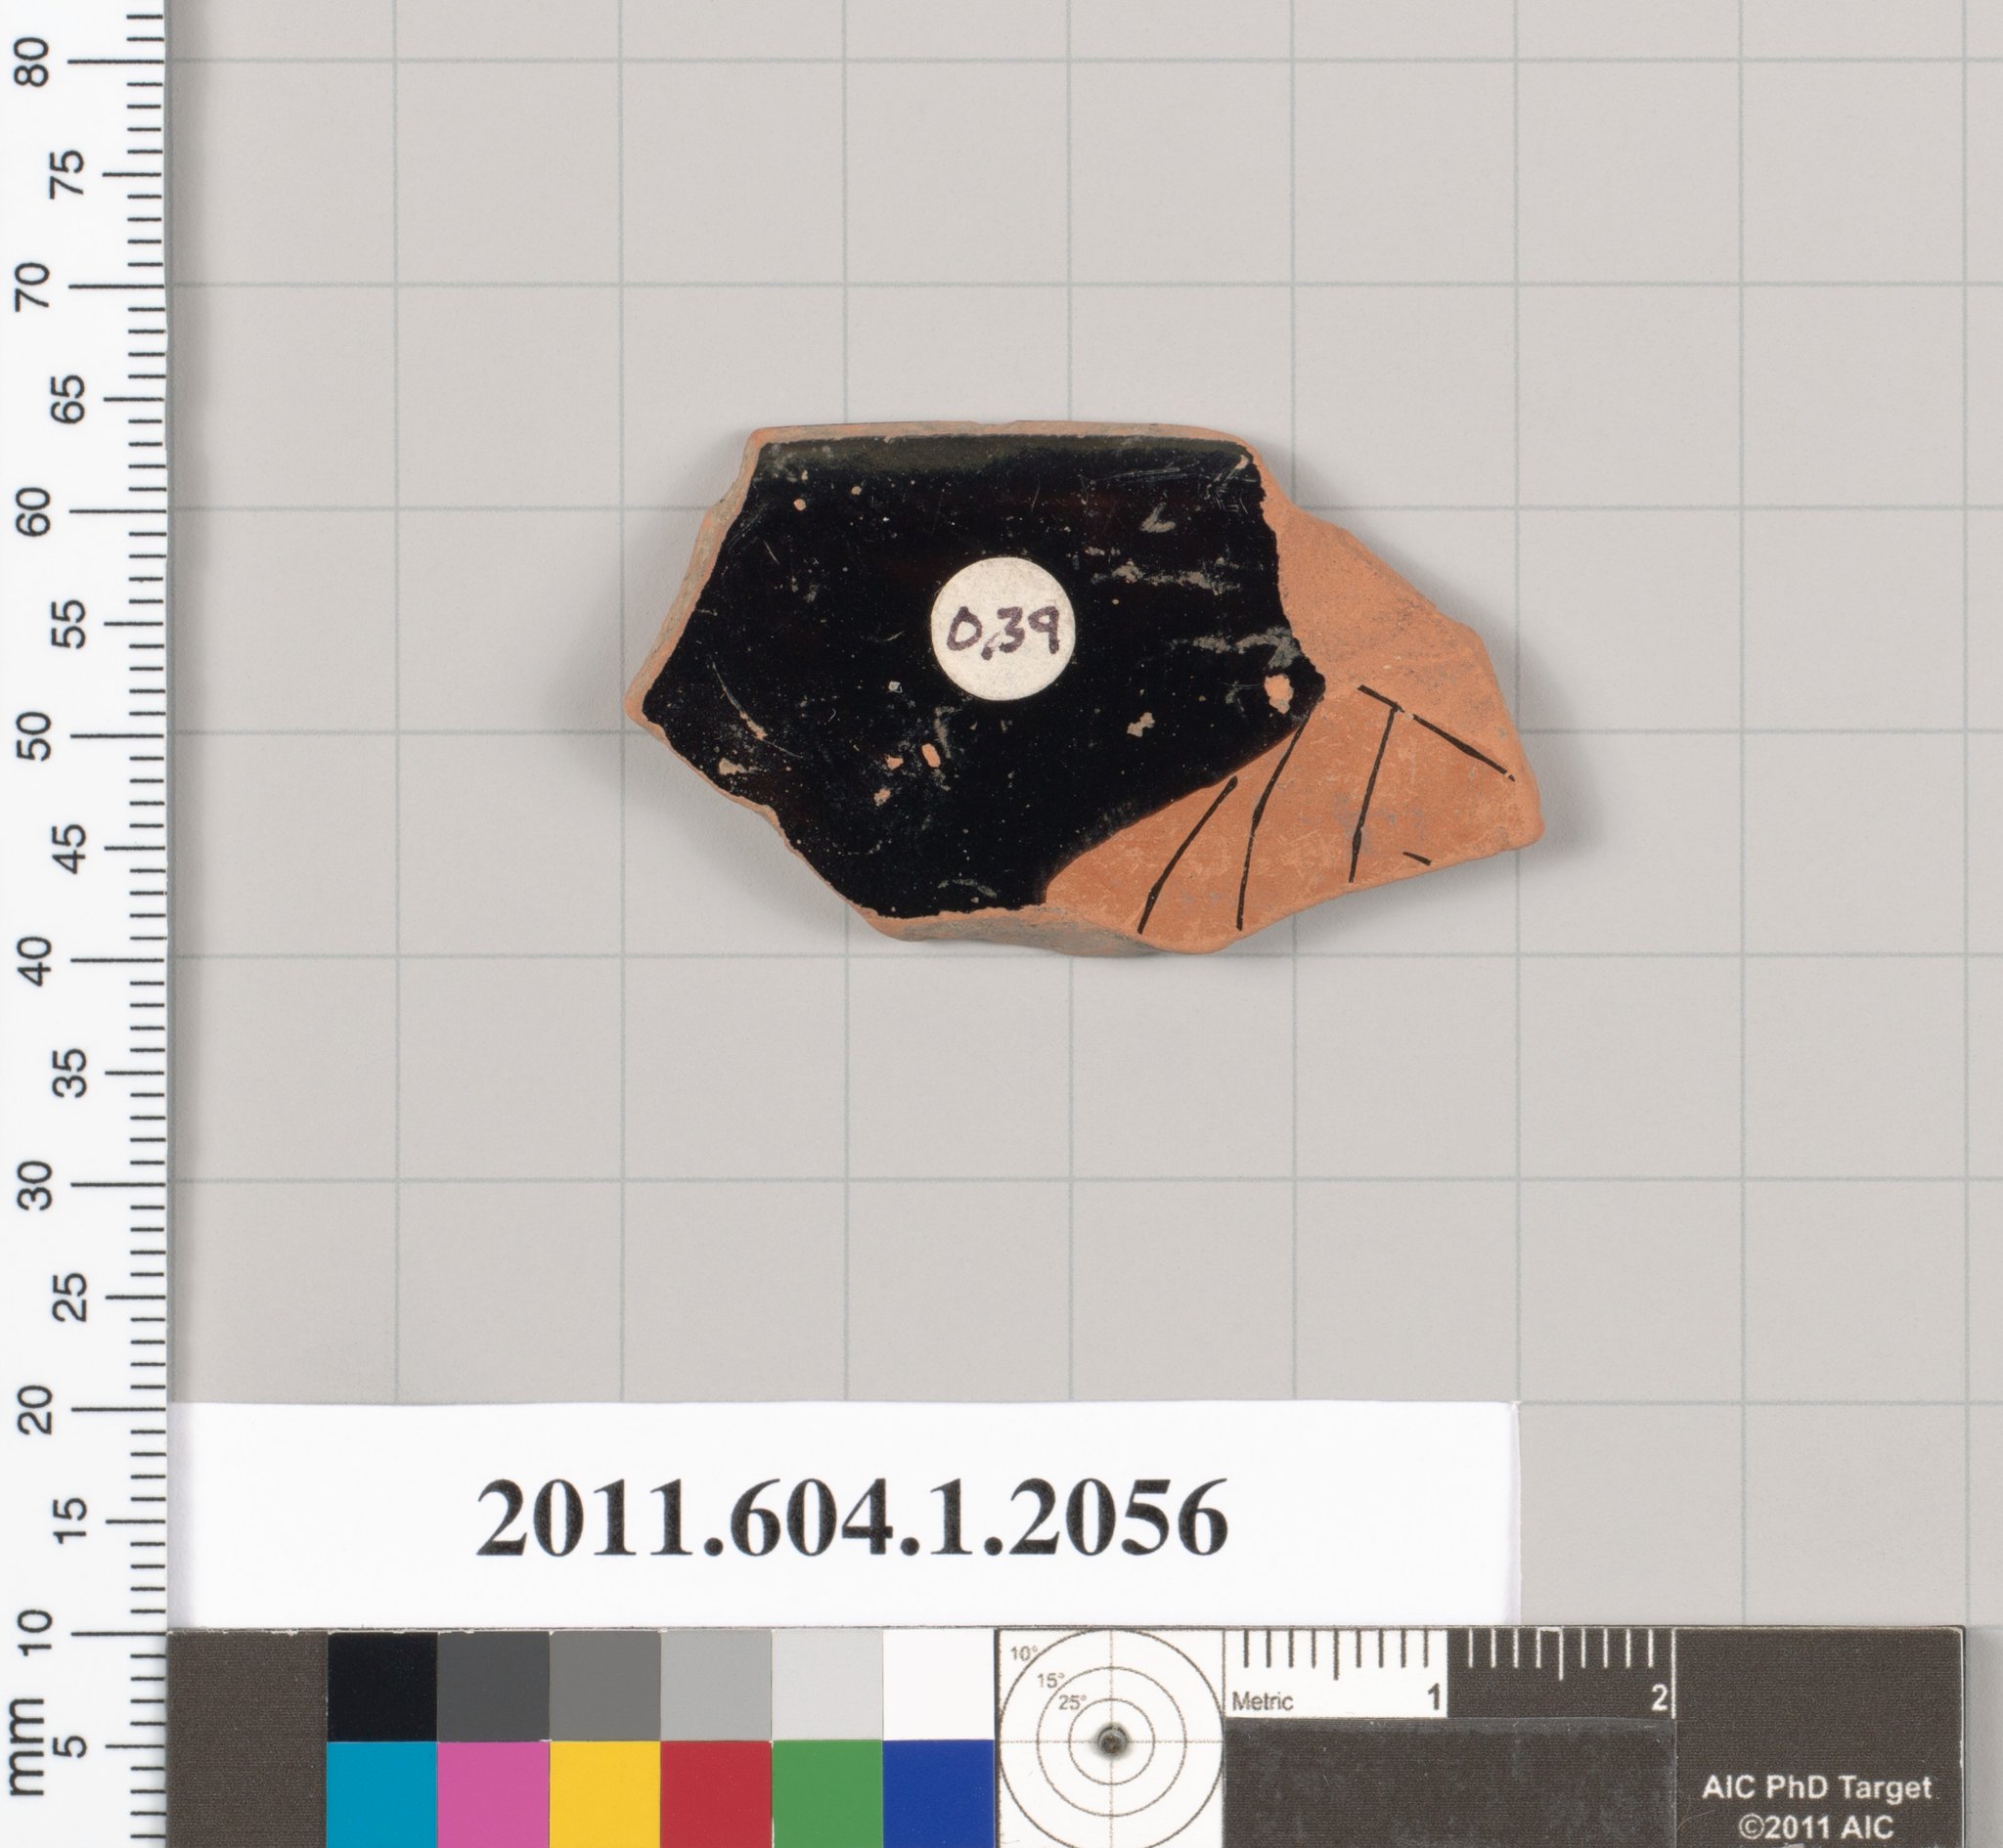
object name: kylix fragment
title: Terracotta rim fragment of a kylix (drinking cup)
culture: greek, attic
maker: brygan group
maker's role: artist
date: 475-451 BCE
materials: terracotta